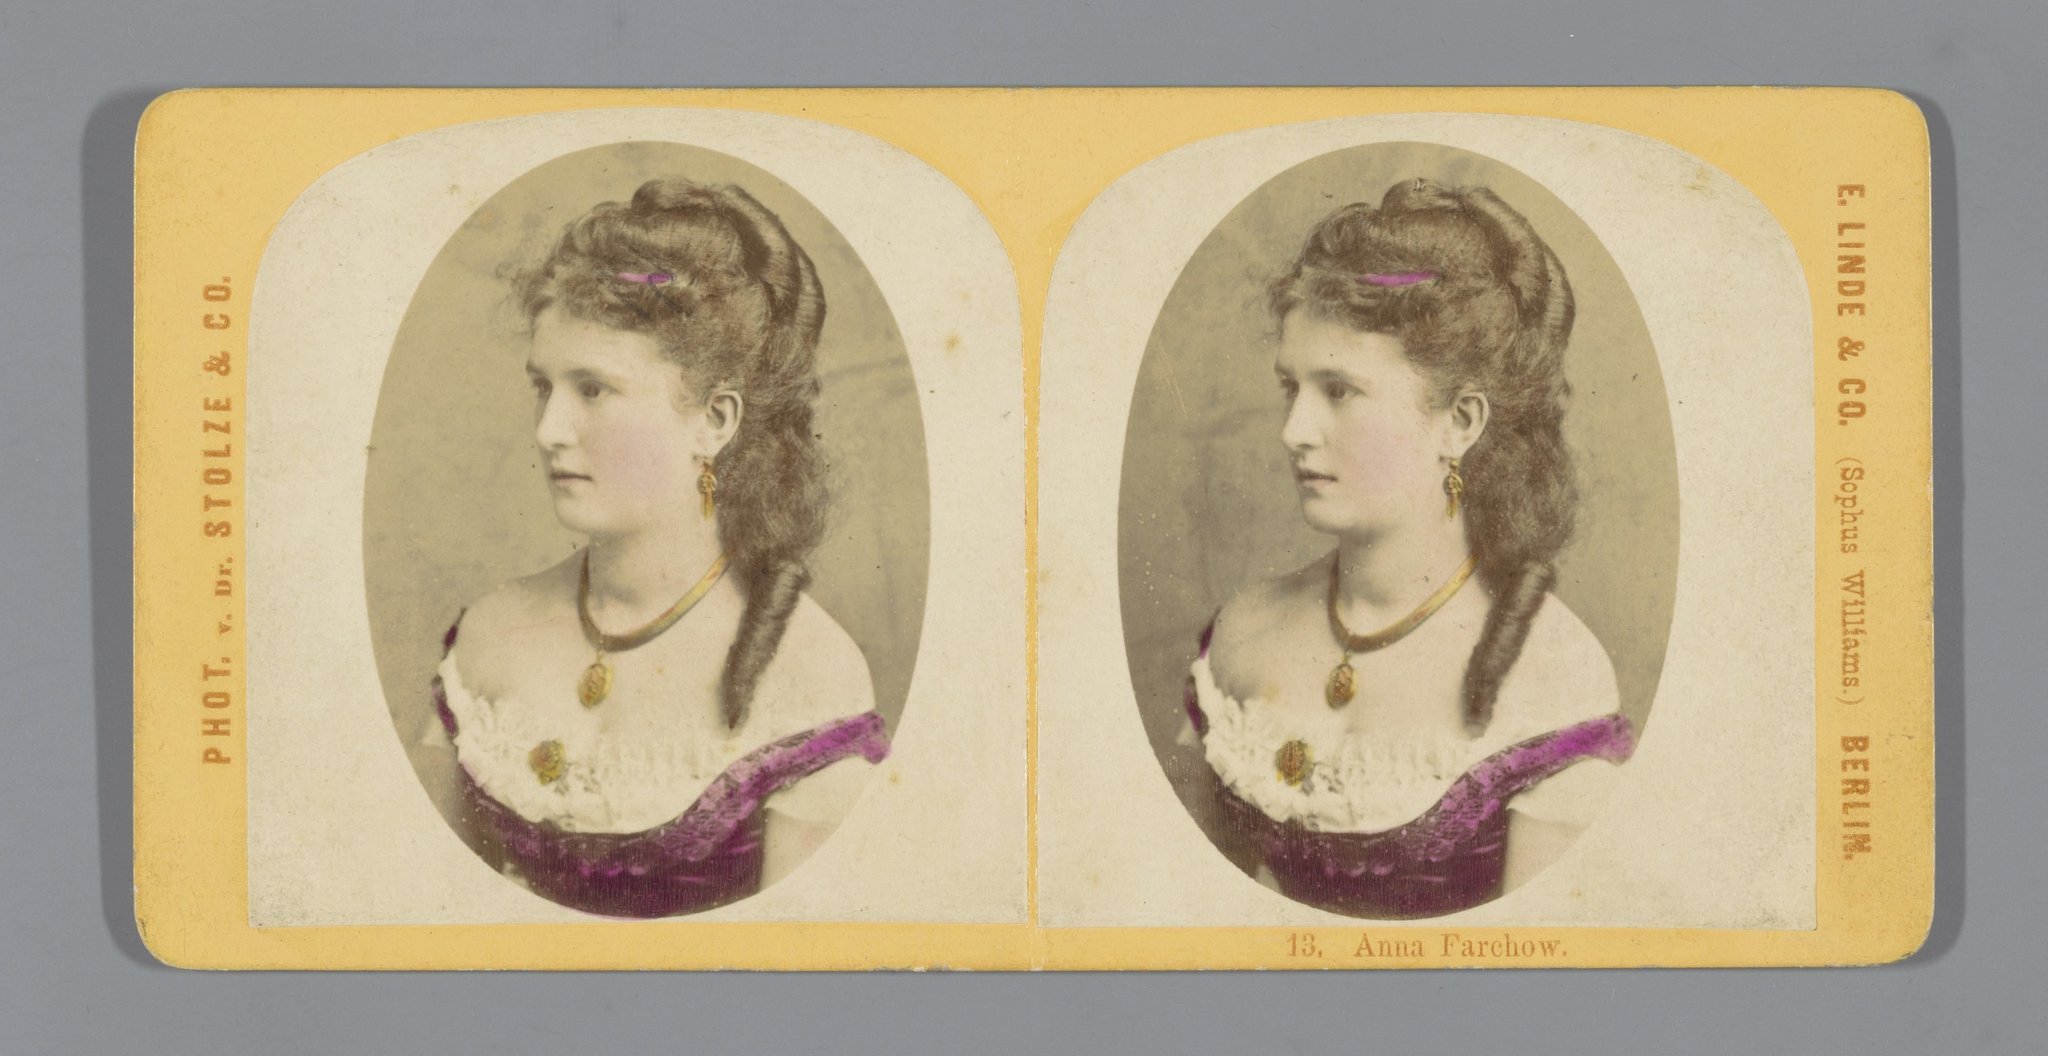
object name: stereograph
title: Portret van Anna Farchow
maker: karl heinrich franz stolze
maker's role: fotograaf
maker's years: 1836-1910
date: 1868-1890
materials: cardboard, paper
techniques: albumen print, hand coloring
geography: berlin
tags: adult woman, historical persons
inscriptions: number: ‘13’